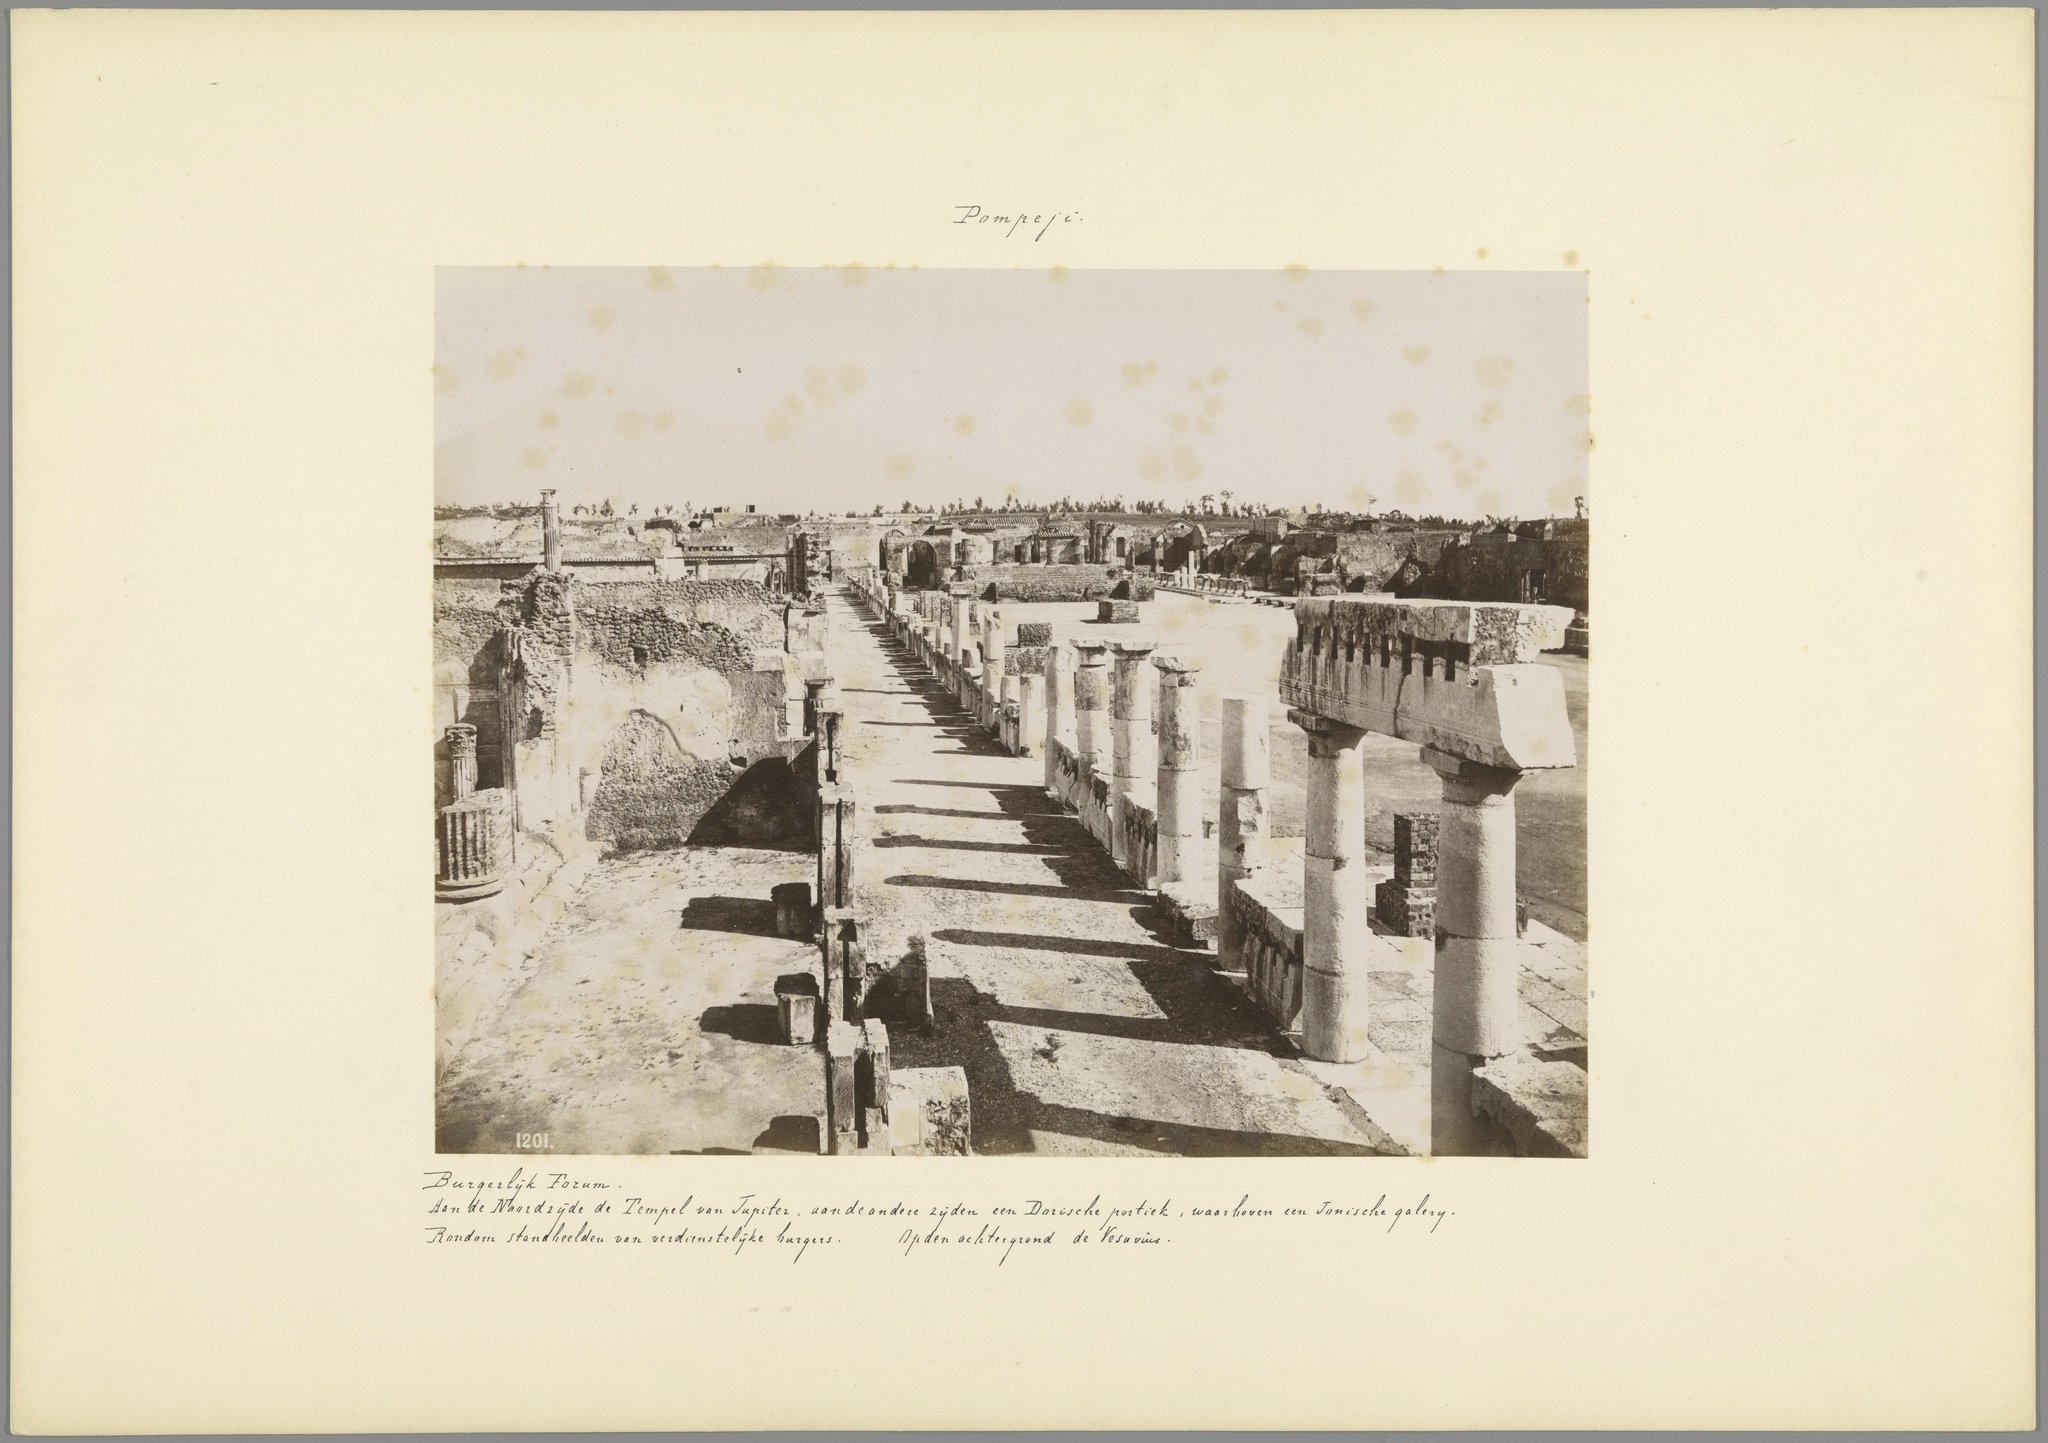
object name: photograph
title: Forum van Pompeï met zicht op de tempel van Jupiter, op de achtergrond de Vesuvius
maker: Anonymous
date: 1875-1900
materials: cardboard, photographic support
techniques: albumen print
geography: foro civile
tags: column, pillar ~ architecture, ruin of a building ~ architecture, temple, shrine ~ non-christian religions, street, village square, place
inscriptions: number: ‘1201.’, collector's mark: ‘INSTITUUT VOOR KUNST-NIJVERHEIDSONDERWIJS GABRIËL METSUSTRAAT No. 16. AMSTERDAM’, collector's mark: ‘KUNSTNIJVERHEIDSCHOOL QUELLINUS AMSTERDAM FRANS HALSSTRAAT 14.’, inscription: ‘Pompeji. Burgerlijk Forum. Aan de Noordzijde de Tempel van Jupiter, aan de andere zijden een Dorische portiek , waarboven een Ionische galerij . Rondom standbeelden van verdienstelijke burgers . Op den achtergrond de Vesuvius.’